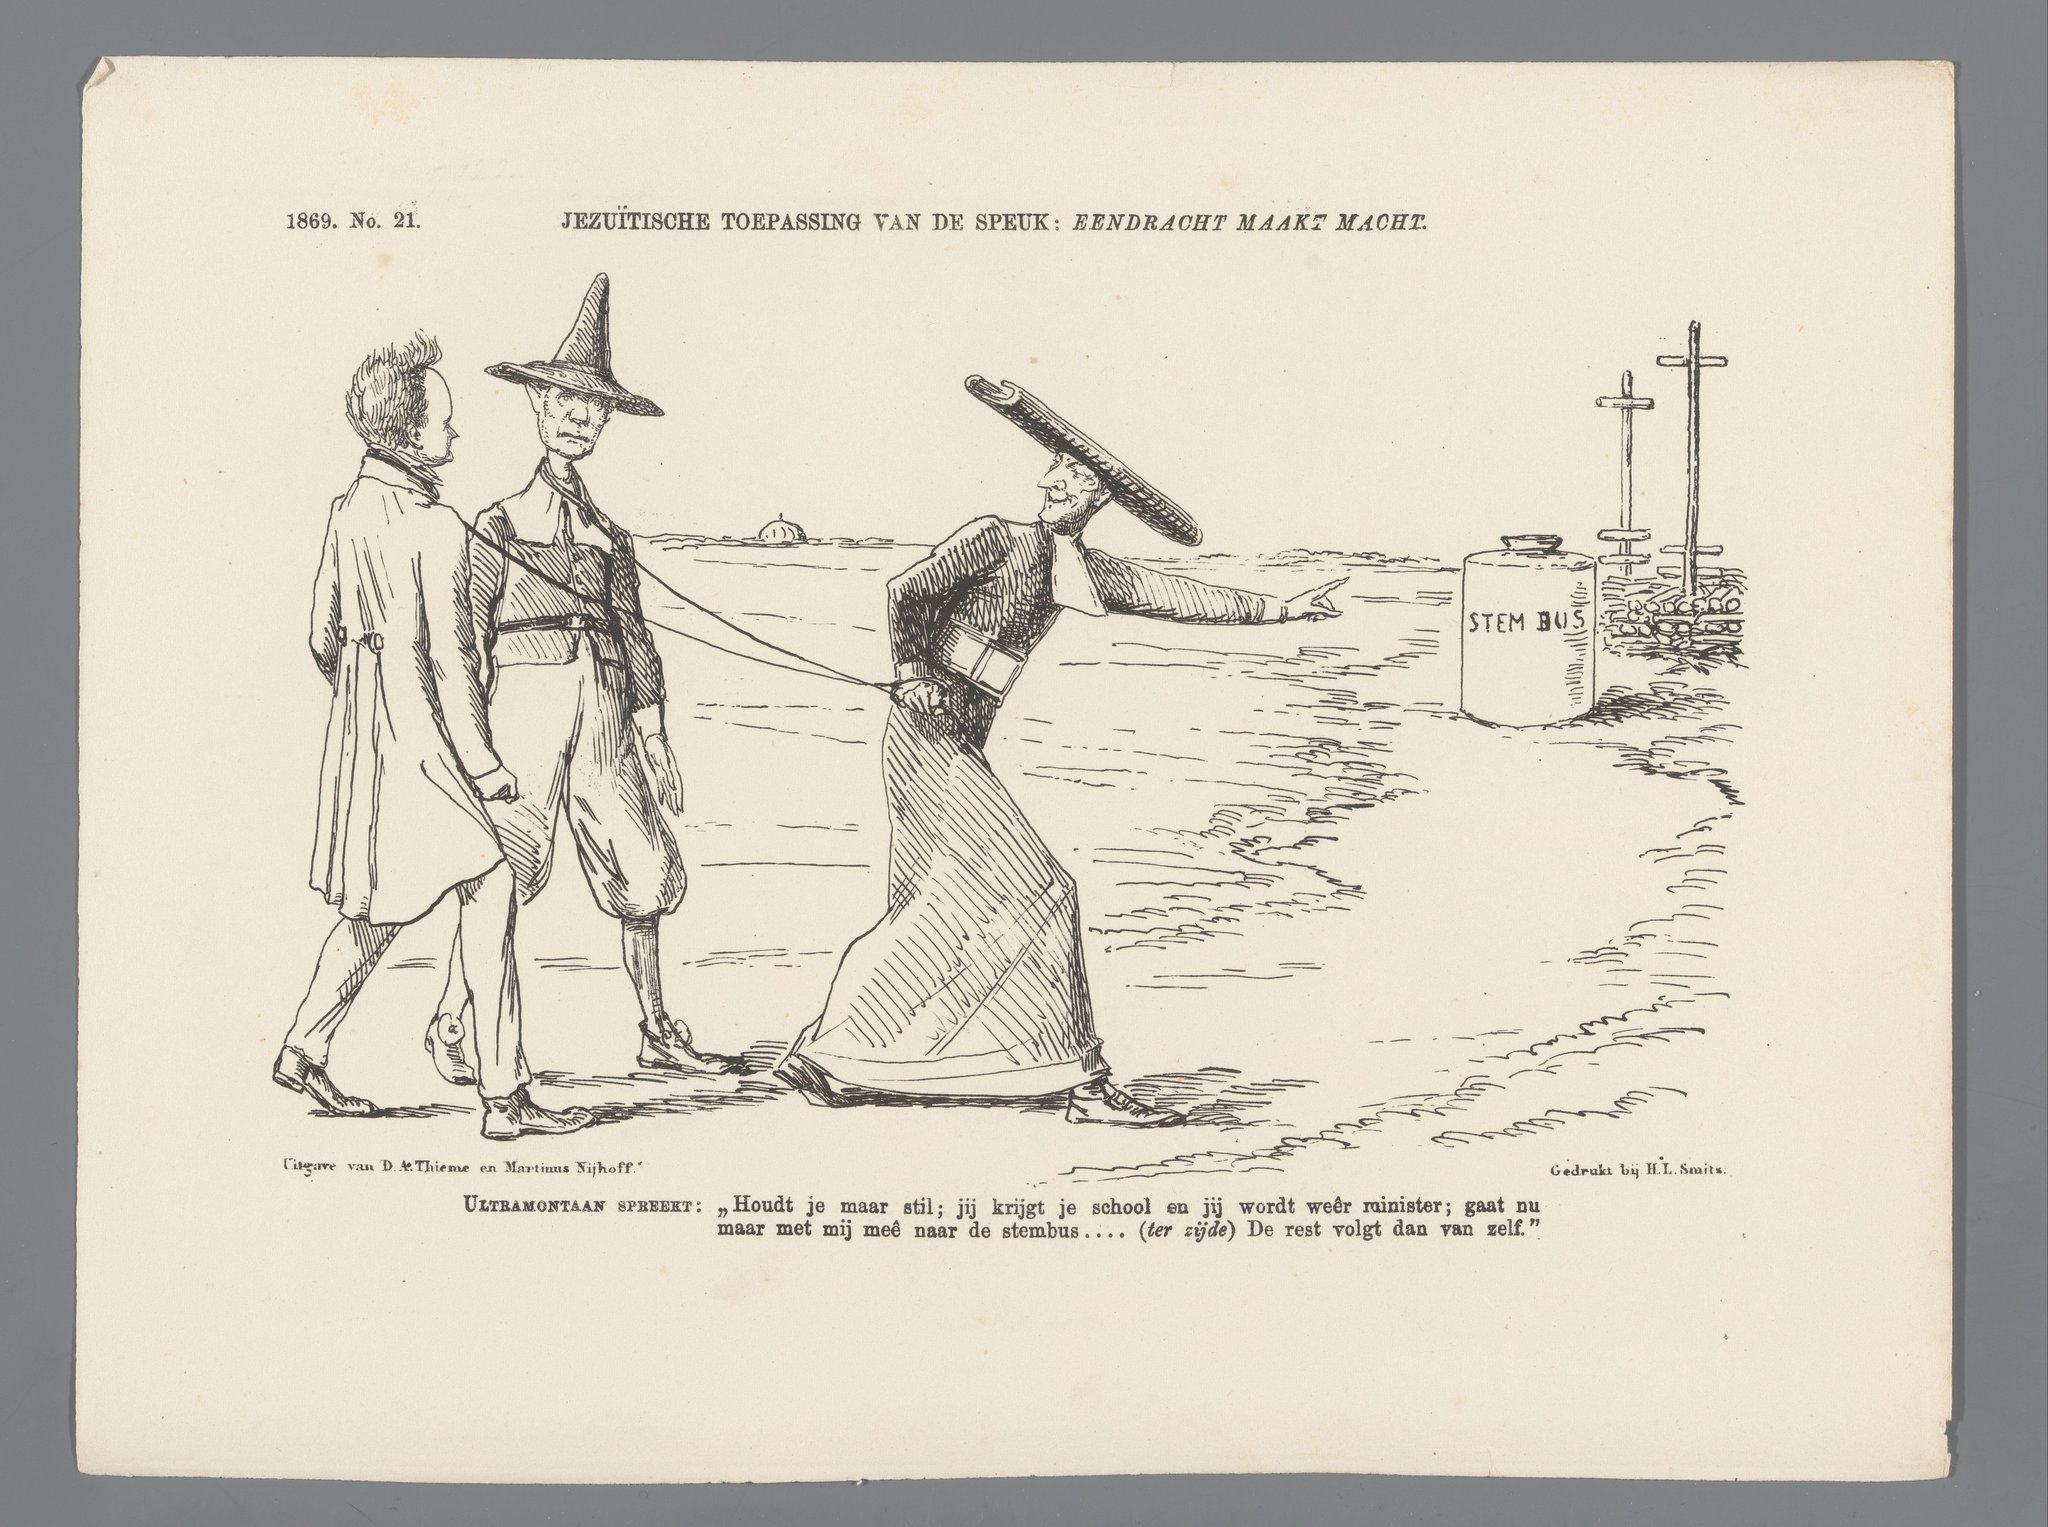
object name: cartoon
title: Jezuïtische toepassing van de spreuk: Eendracht maakt Macht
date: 1869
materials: paper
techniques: lithograph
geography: netherlands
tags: voting place, polling station, regular clerics, e.g. jesuits, redemptorists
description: Spotprent waarin een jezuïet Heemskerk en een anti-revolutionair aan een leiband naar de stembus leidt. Plaat verschenen bij het weekblad De Nederlandsche Spectator, nr. 21, 1869.